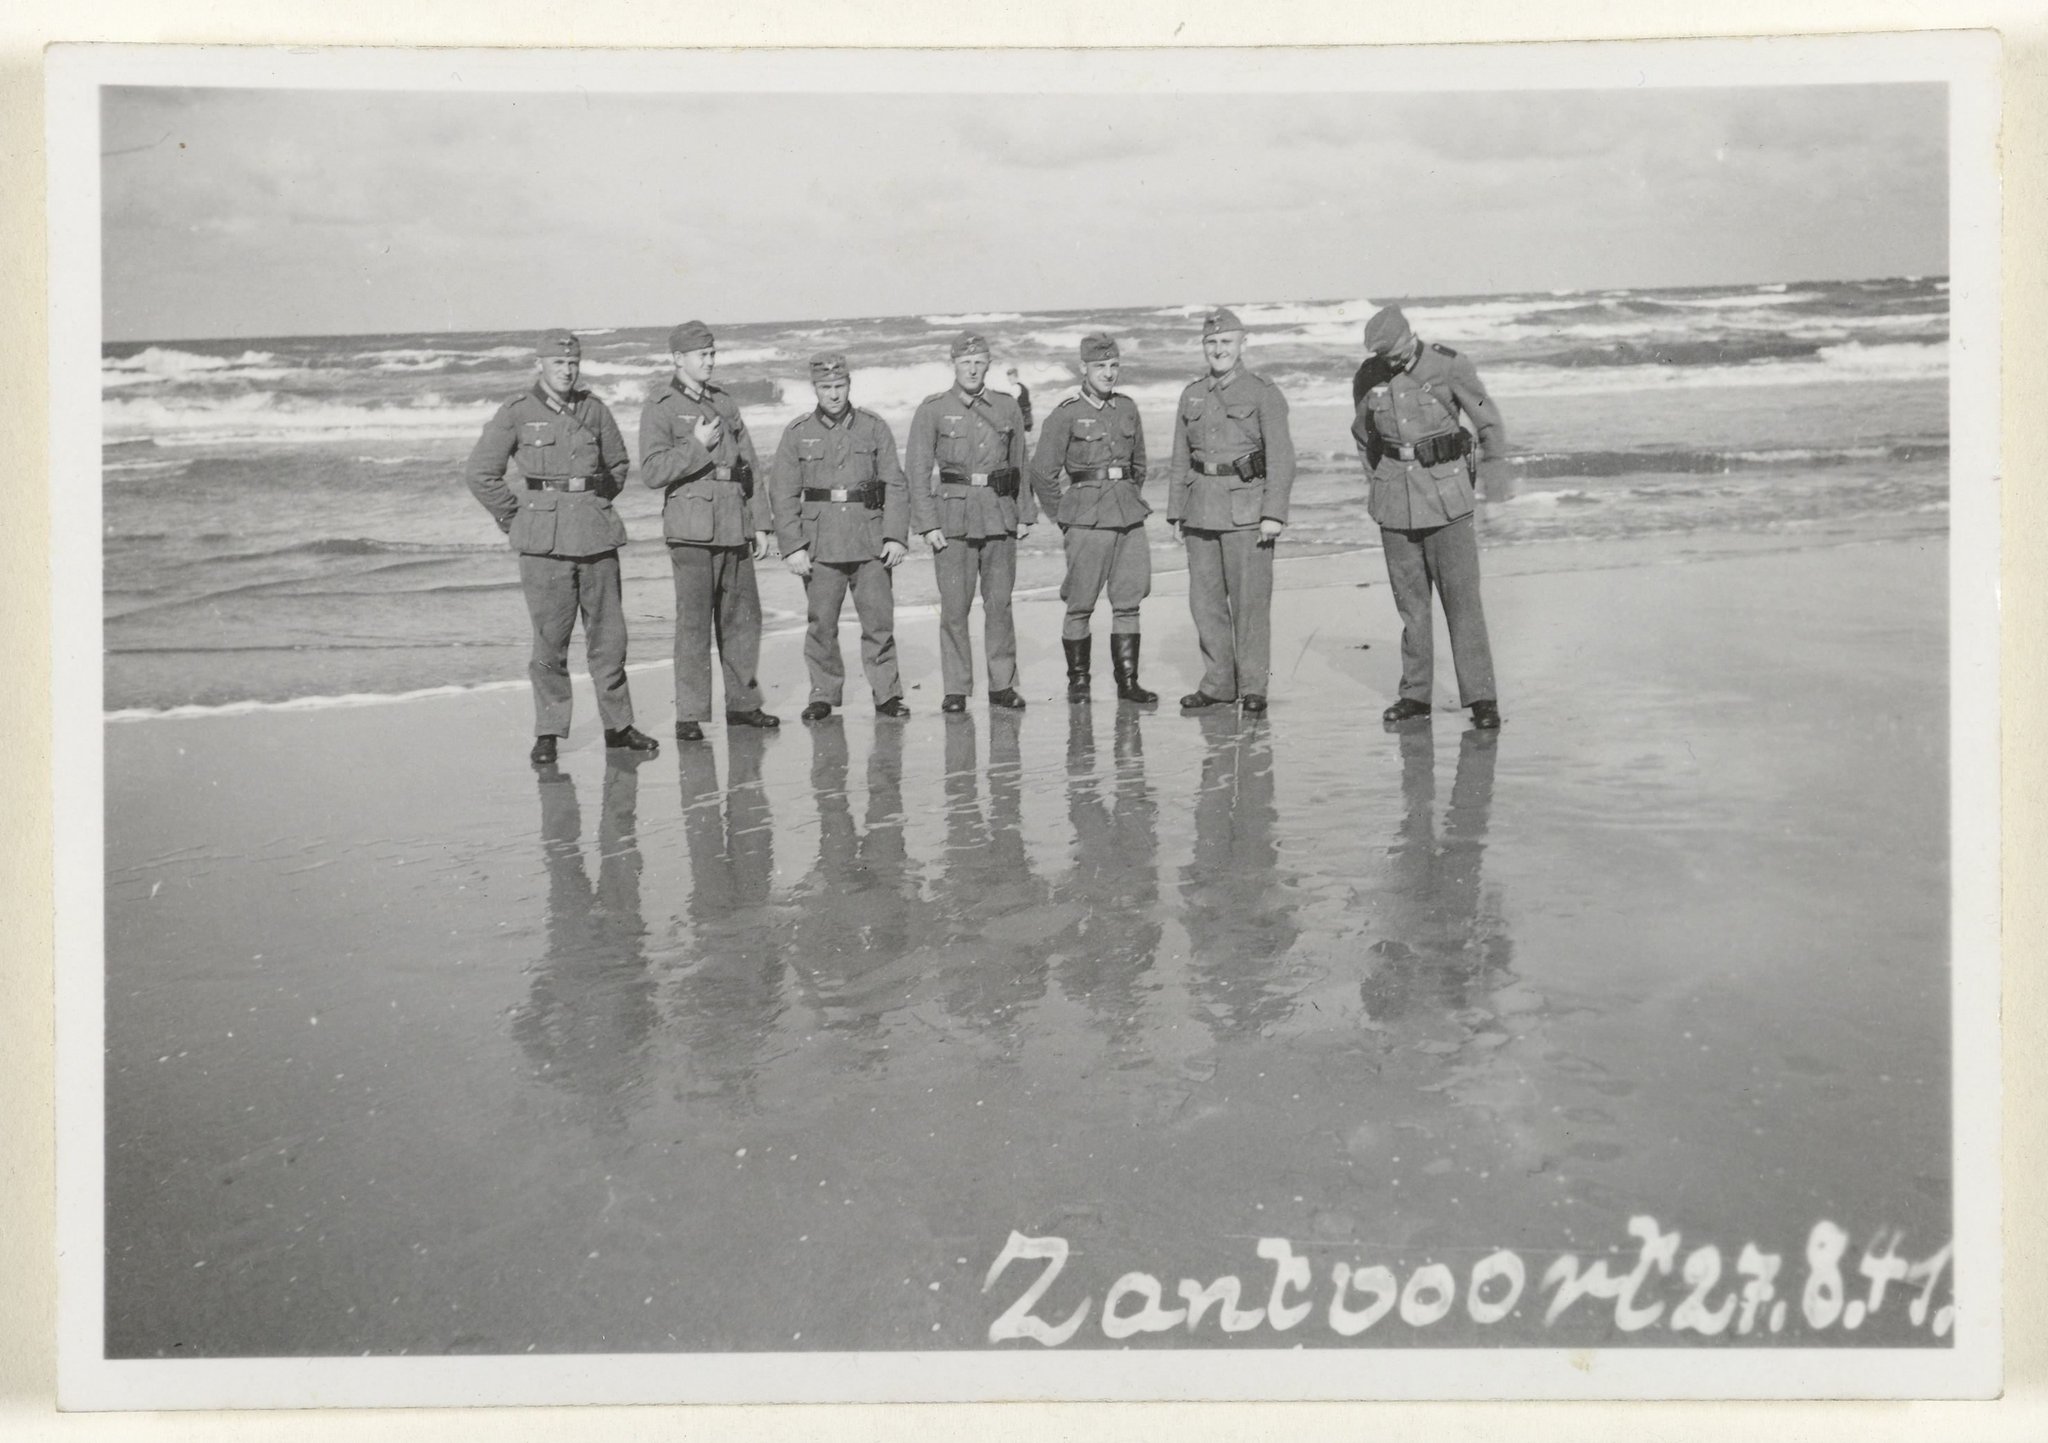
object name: photograph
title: Duitse soldaten in Zandvoort, 1941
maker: Anonymous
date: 1941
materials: photographic support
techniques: photography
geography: zandvoort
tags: the company, the unit, the troop ~ military service, occupation ~ war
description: Amateurfoto van Duitse soldaten uit 1941 in Zandvoort. Zeven mannen staan in uniform aan de rand van zee.